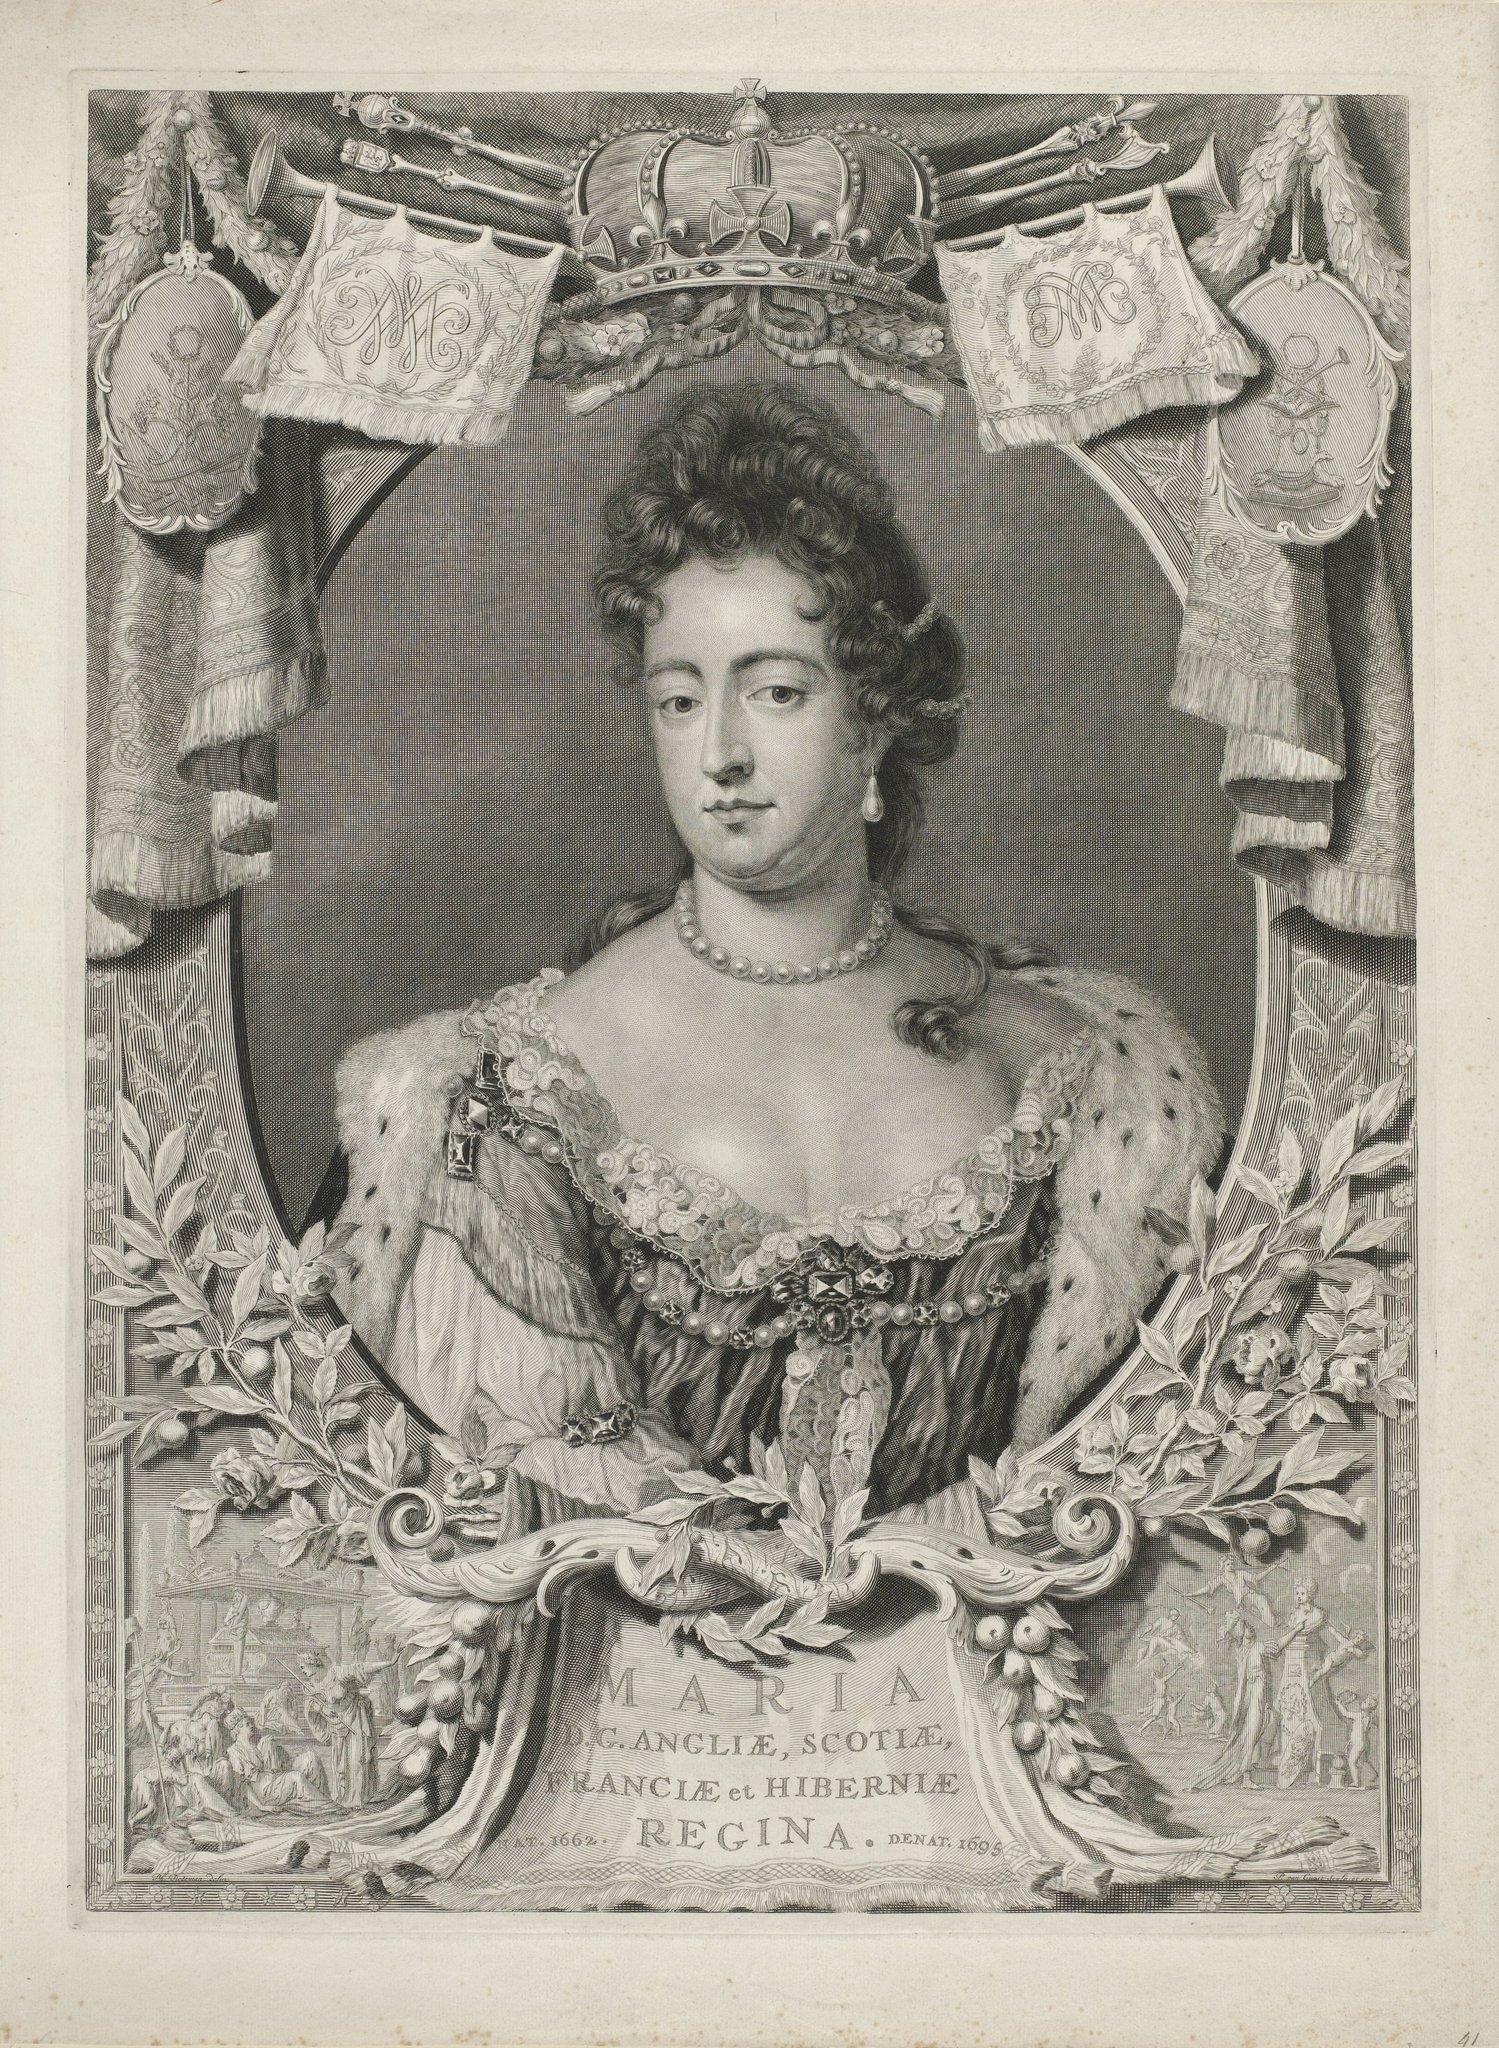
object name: print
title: Portret van Maria II Stuart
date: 1695-1731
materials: paper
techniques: engraving, etching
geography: amsterdam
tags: london, maria ii stuart (koningin van engeland, schotland en ierland)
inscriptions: collector's mark: Lugt 240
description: Portret van Maria II in een geornamenteerd ovaal met oranjetakken. Daar omheen een aantal allegorische objecten. Midden boven een kroon. Links- en rechtsonder zinnebeelden op haar dood. Op een doek haar geboortejaar, sterfjaar en haar naam en titels.